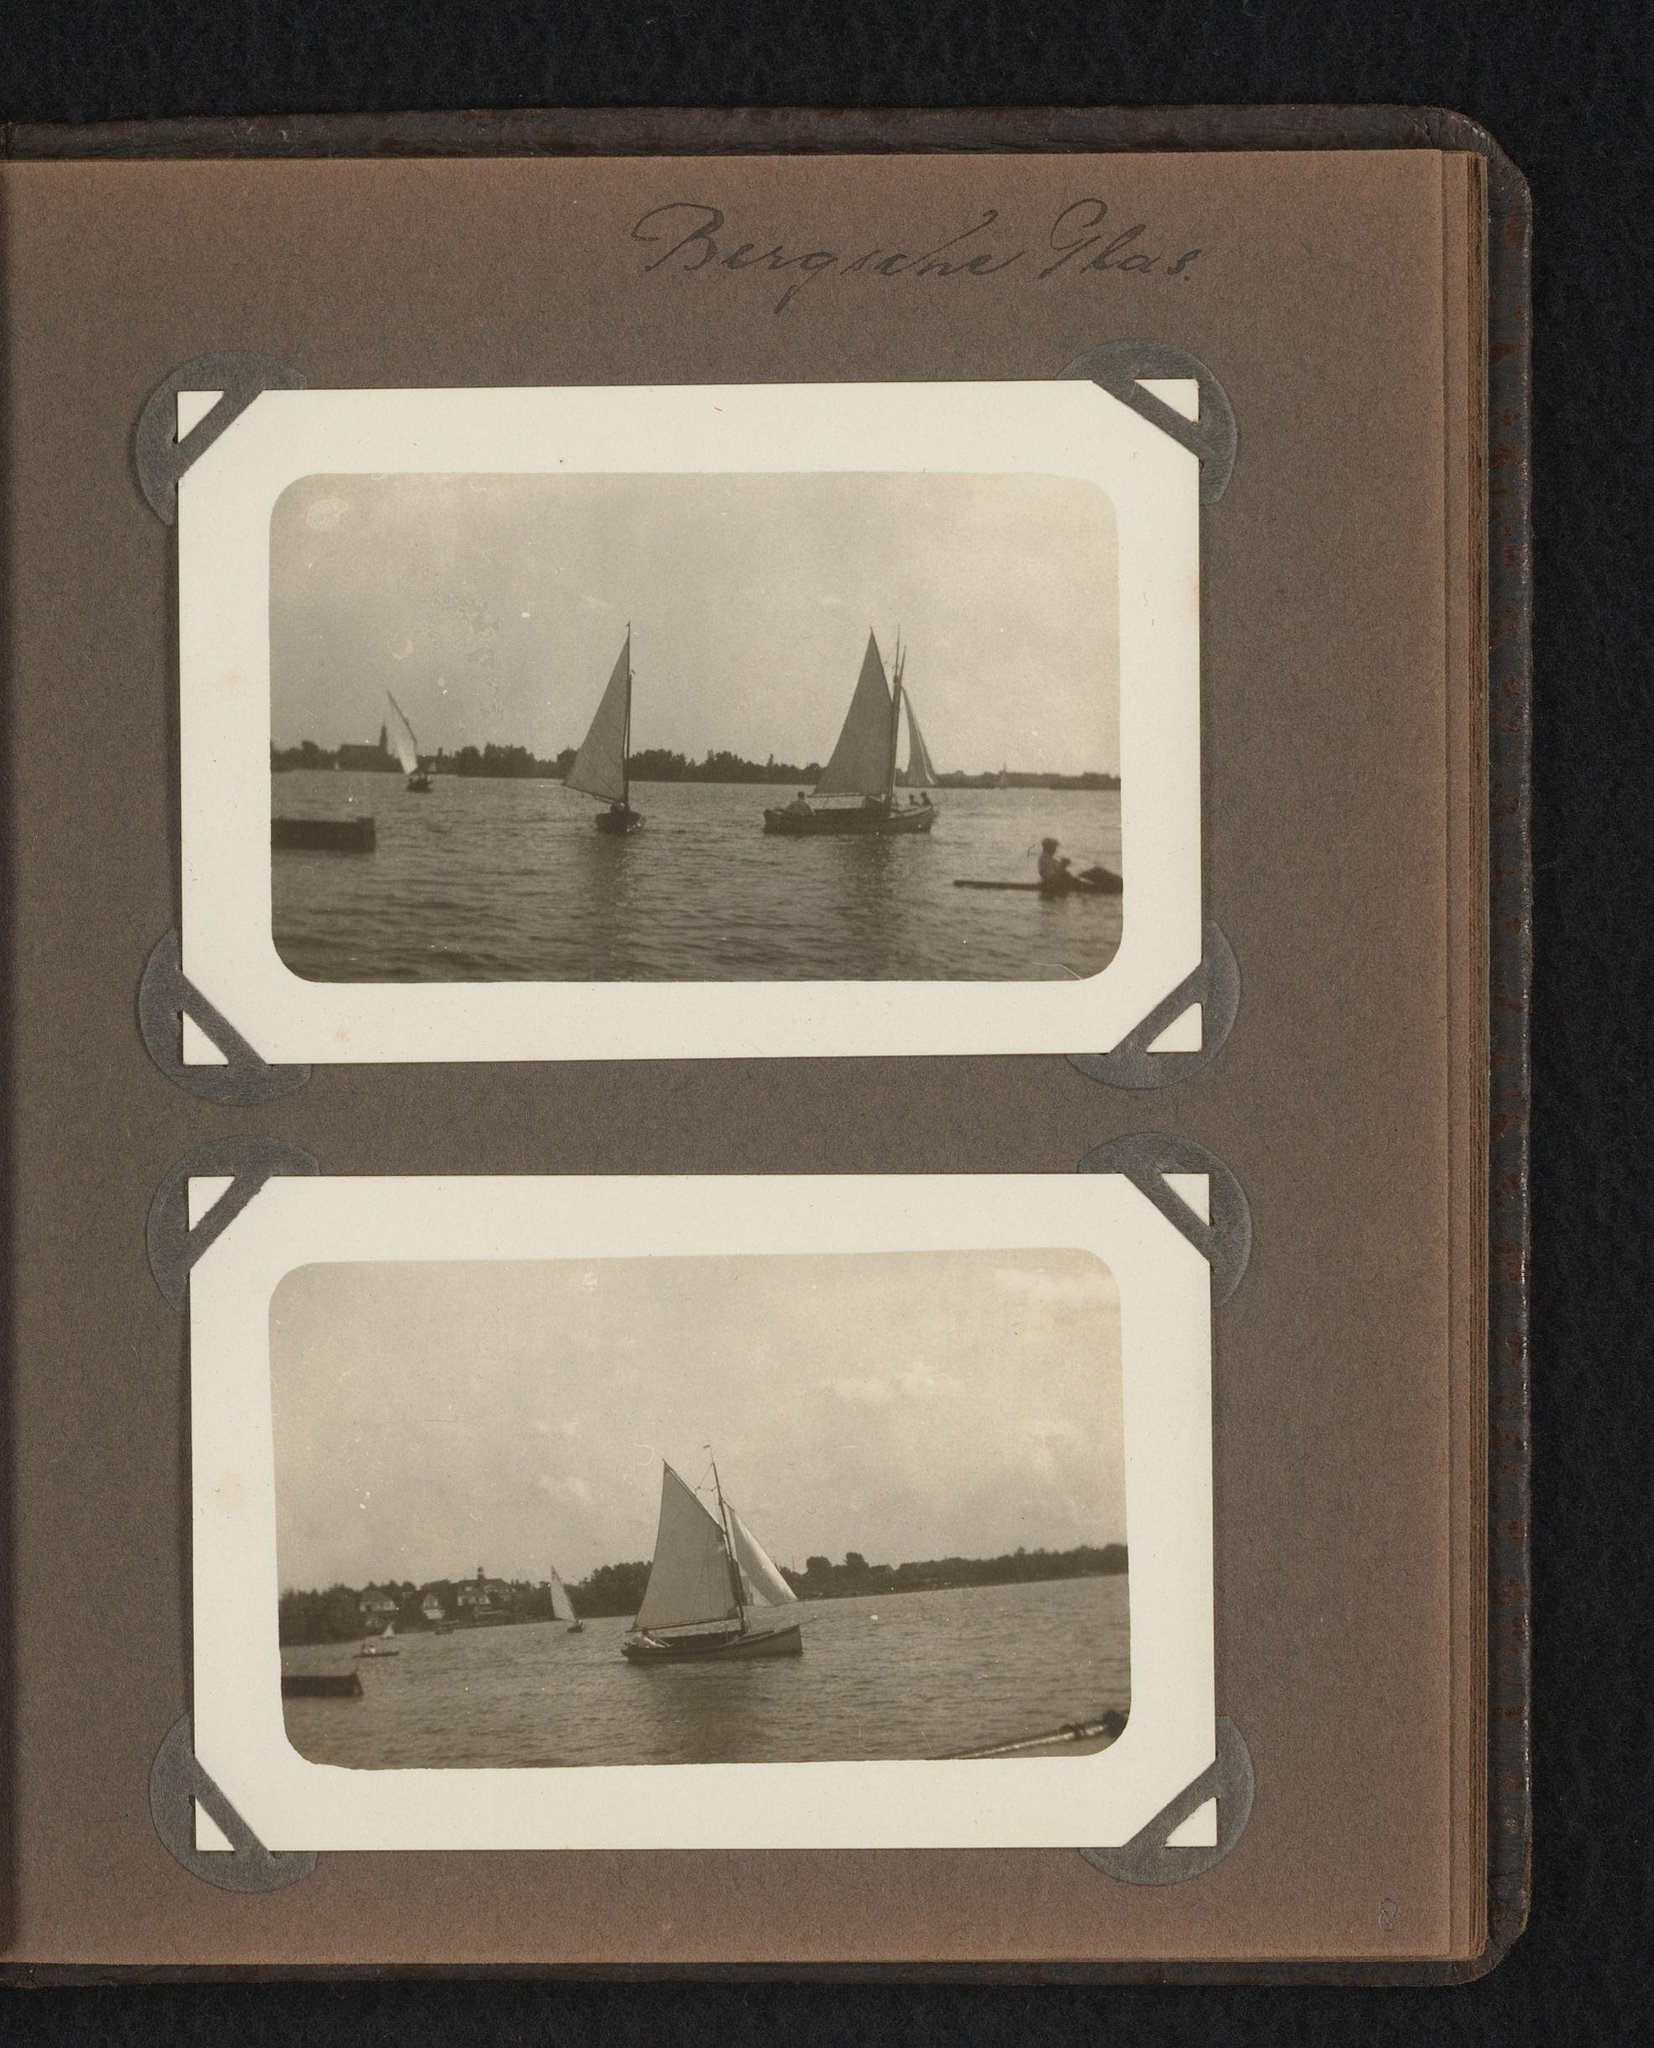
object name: photograph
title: Bergsche Plas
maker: Anonymous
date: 1929-1930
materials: paper, photographic support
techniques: gelatin silver print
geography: rotterdam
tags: sailing-ship, sailing-boat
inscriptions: inscription: ‘Bergsche Plas’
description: Albumblad met twee foto's van zeilboten op het water van de Bergse Plassen. Onderdeel van het fotoalbum Graf Zeppelin.